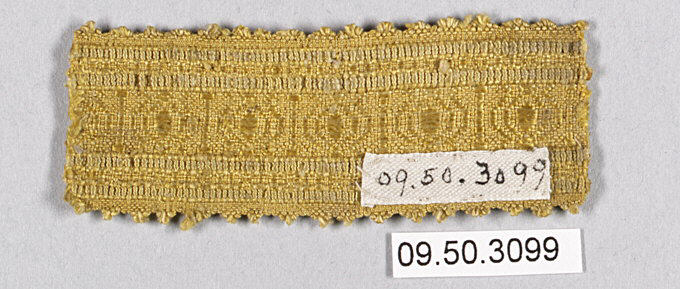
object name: gimp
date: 1701-1900